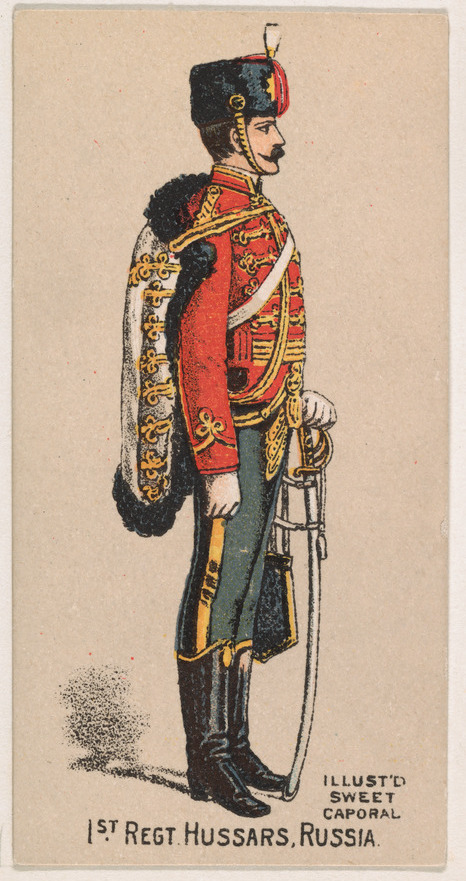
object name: print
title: 1st Regiment of Hussars, Russia, from the Military Series (N224) issued by Kinney Tobacco Company to promote Sweet Caporal Cigarettes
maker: kinney brothers tobacco company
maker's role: publisher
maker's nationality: american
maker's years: 1869-2011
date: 1888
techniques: color lithograph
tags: military,soldiers,men,profiles